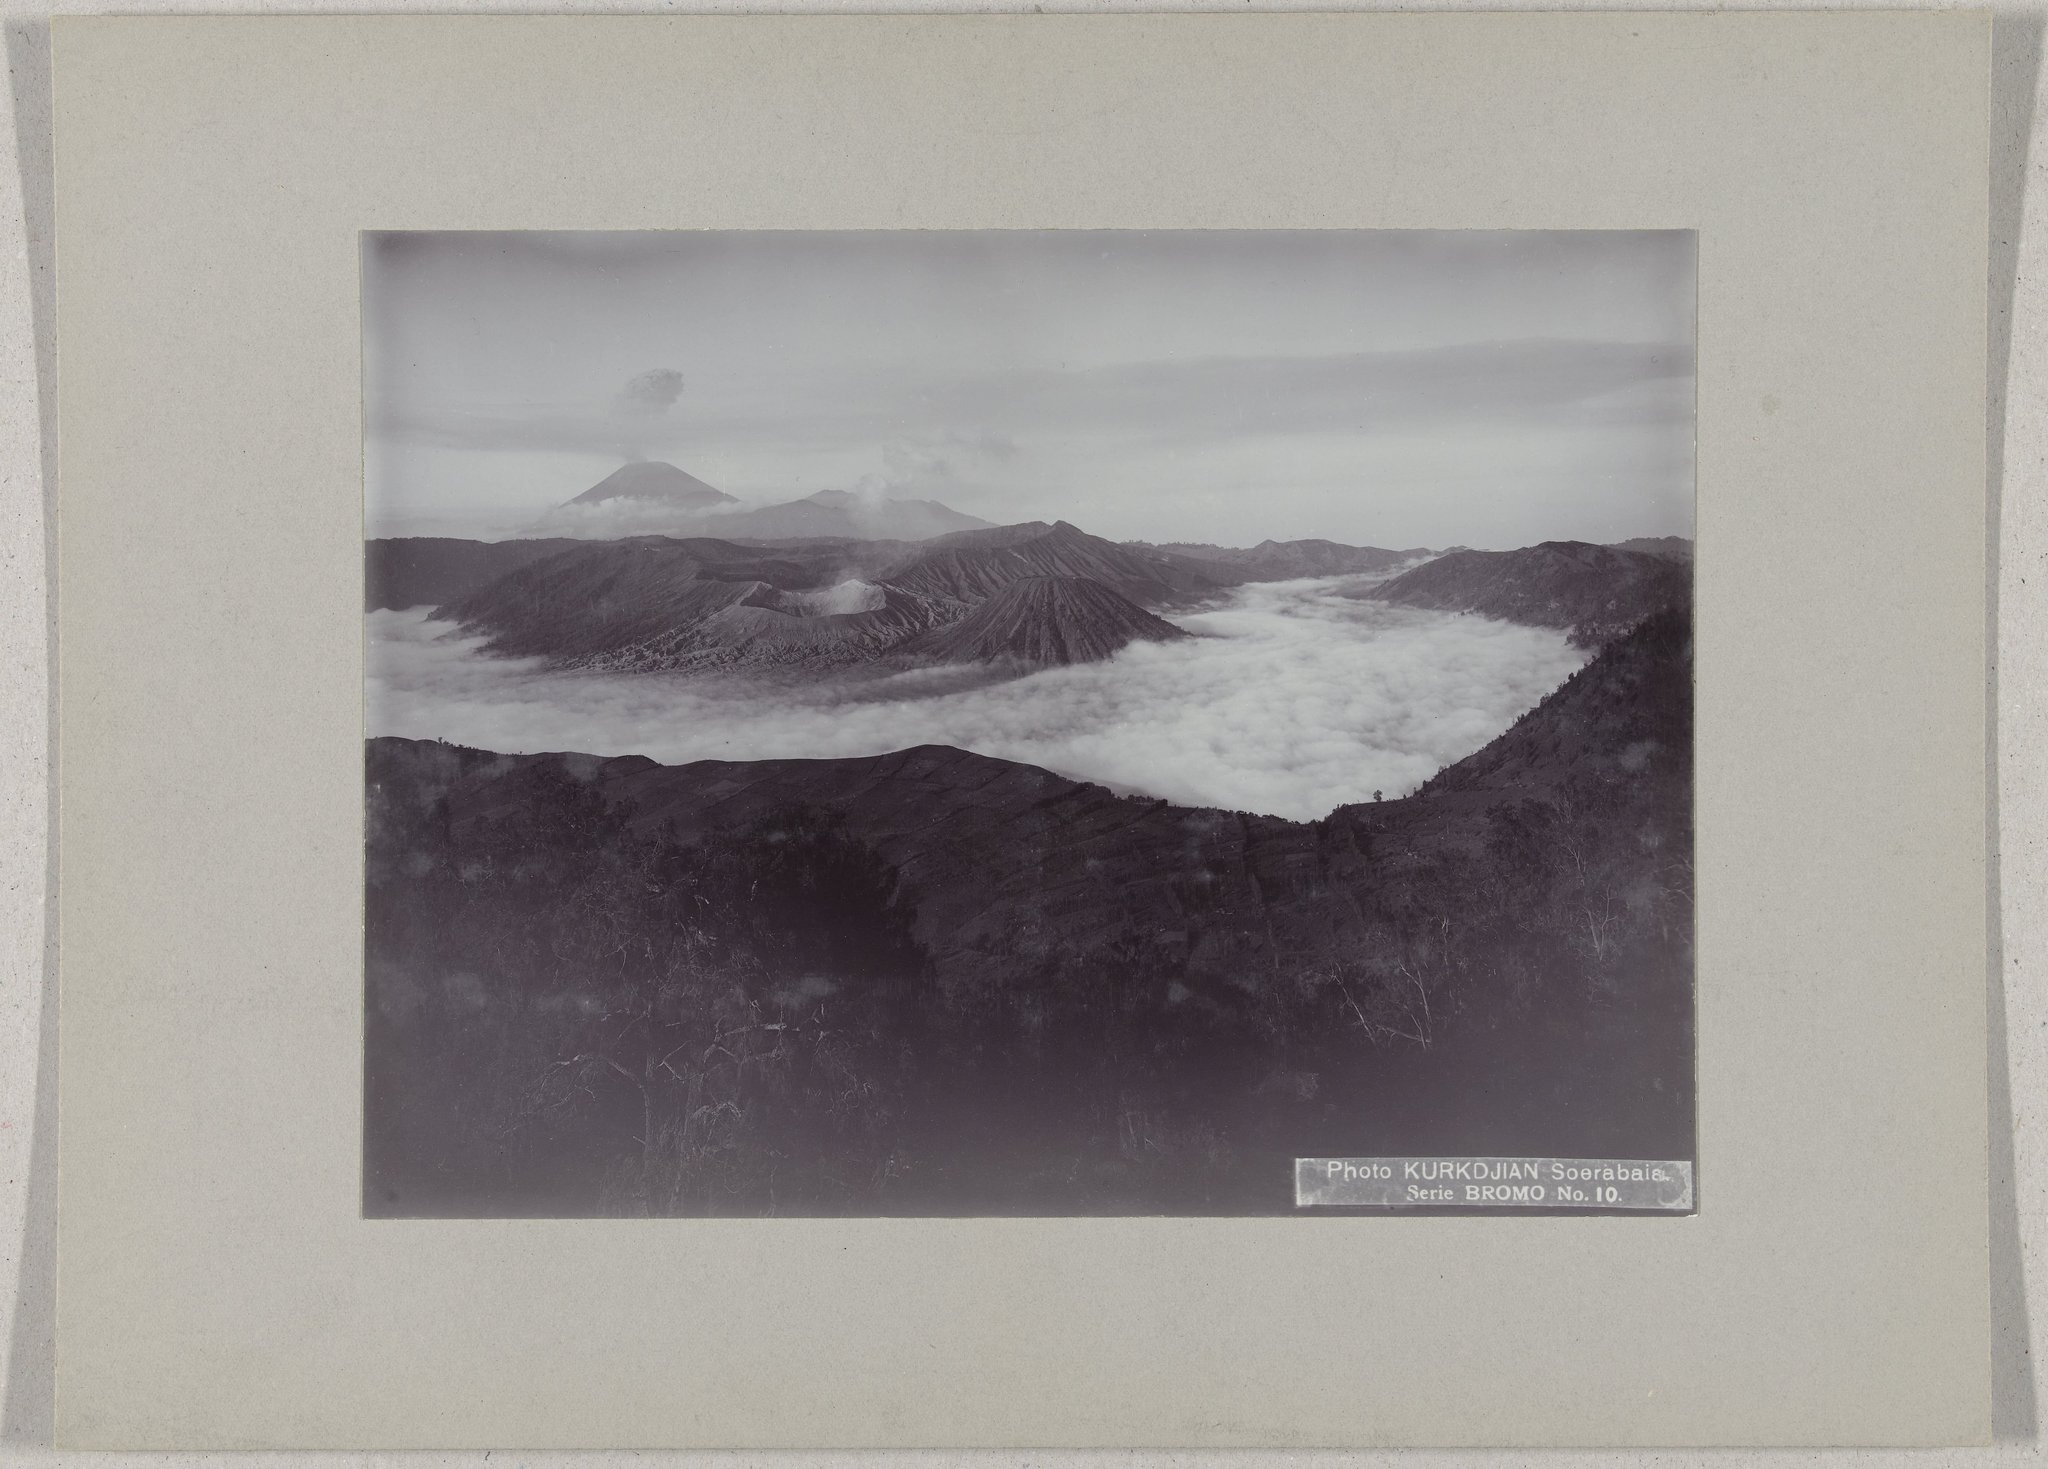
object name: photograph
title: Photo Kurkdjian Soerabaia / Serie Bromo No. 10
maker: onnes kurkdjian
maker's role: fotograaf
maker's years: 1851-1903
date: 1895-1915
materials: cardboard, paper, photographic support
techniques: gelatin silver print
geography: java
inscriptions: number: ‘92’, name: ‘Photo Kurkdjian Soerabaia / Serie Bromo No. 10’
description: Vulkanen (waaronder de Bromo) in het Tenggergebergte, Java, Nederlands-Indië